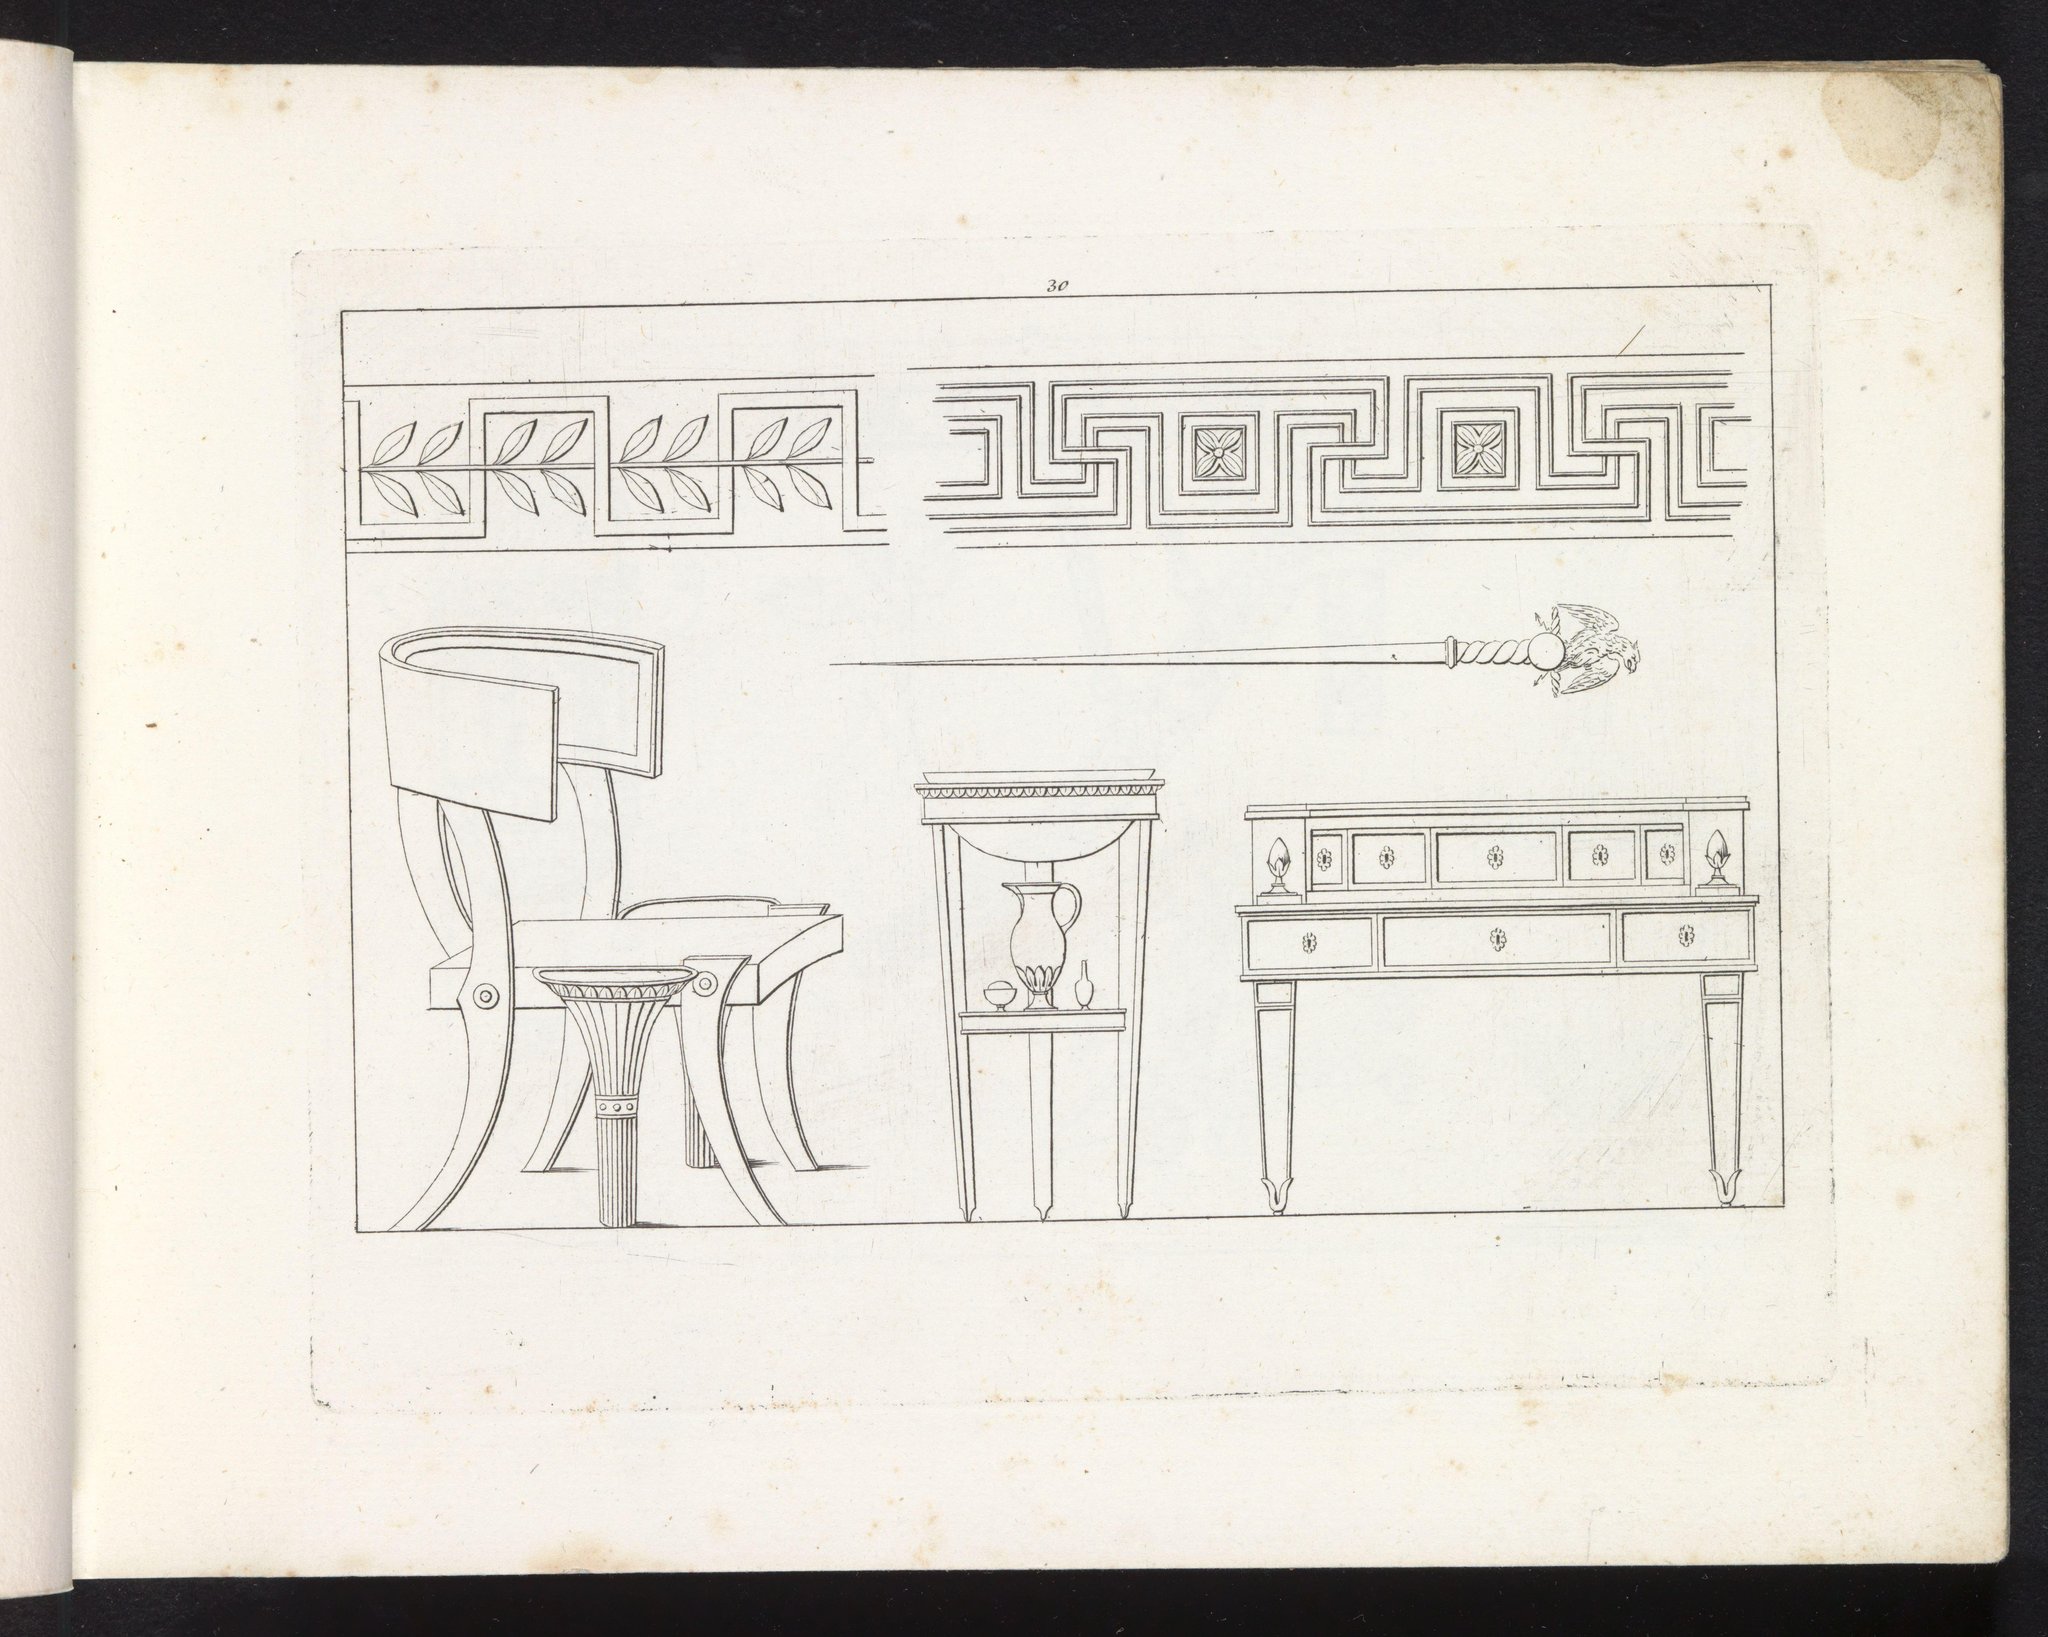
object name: album leaf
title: Ontwerpen voor religieuze en profane voorwerpen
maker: pietro ruga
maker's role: print maker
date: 1817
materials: paper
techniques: etching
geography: italy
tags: writing-table, writing-desk, ornaments ~ art, hacking and thrusting weapons: sword, table, chair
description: Prent maakt deel uit van een reeks van 100 prenten (+ titelprent) met ontwerpen voor religieuze en profane voorwerpen.